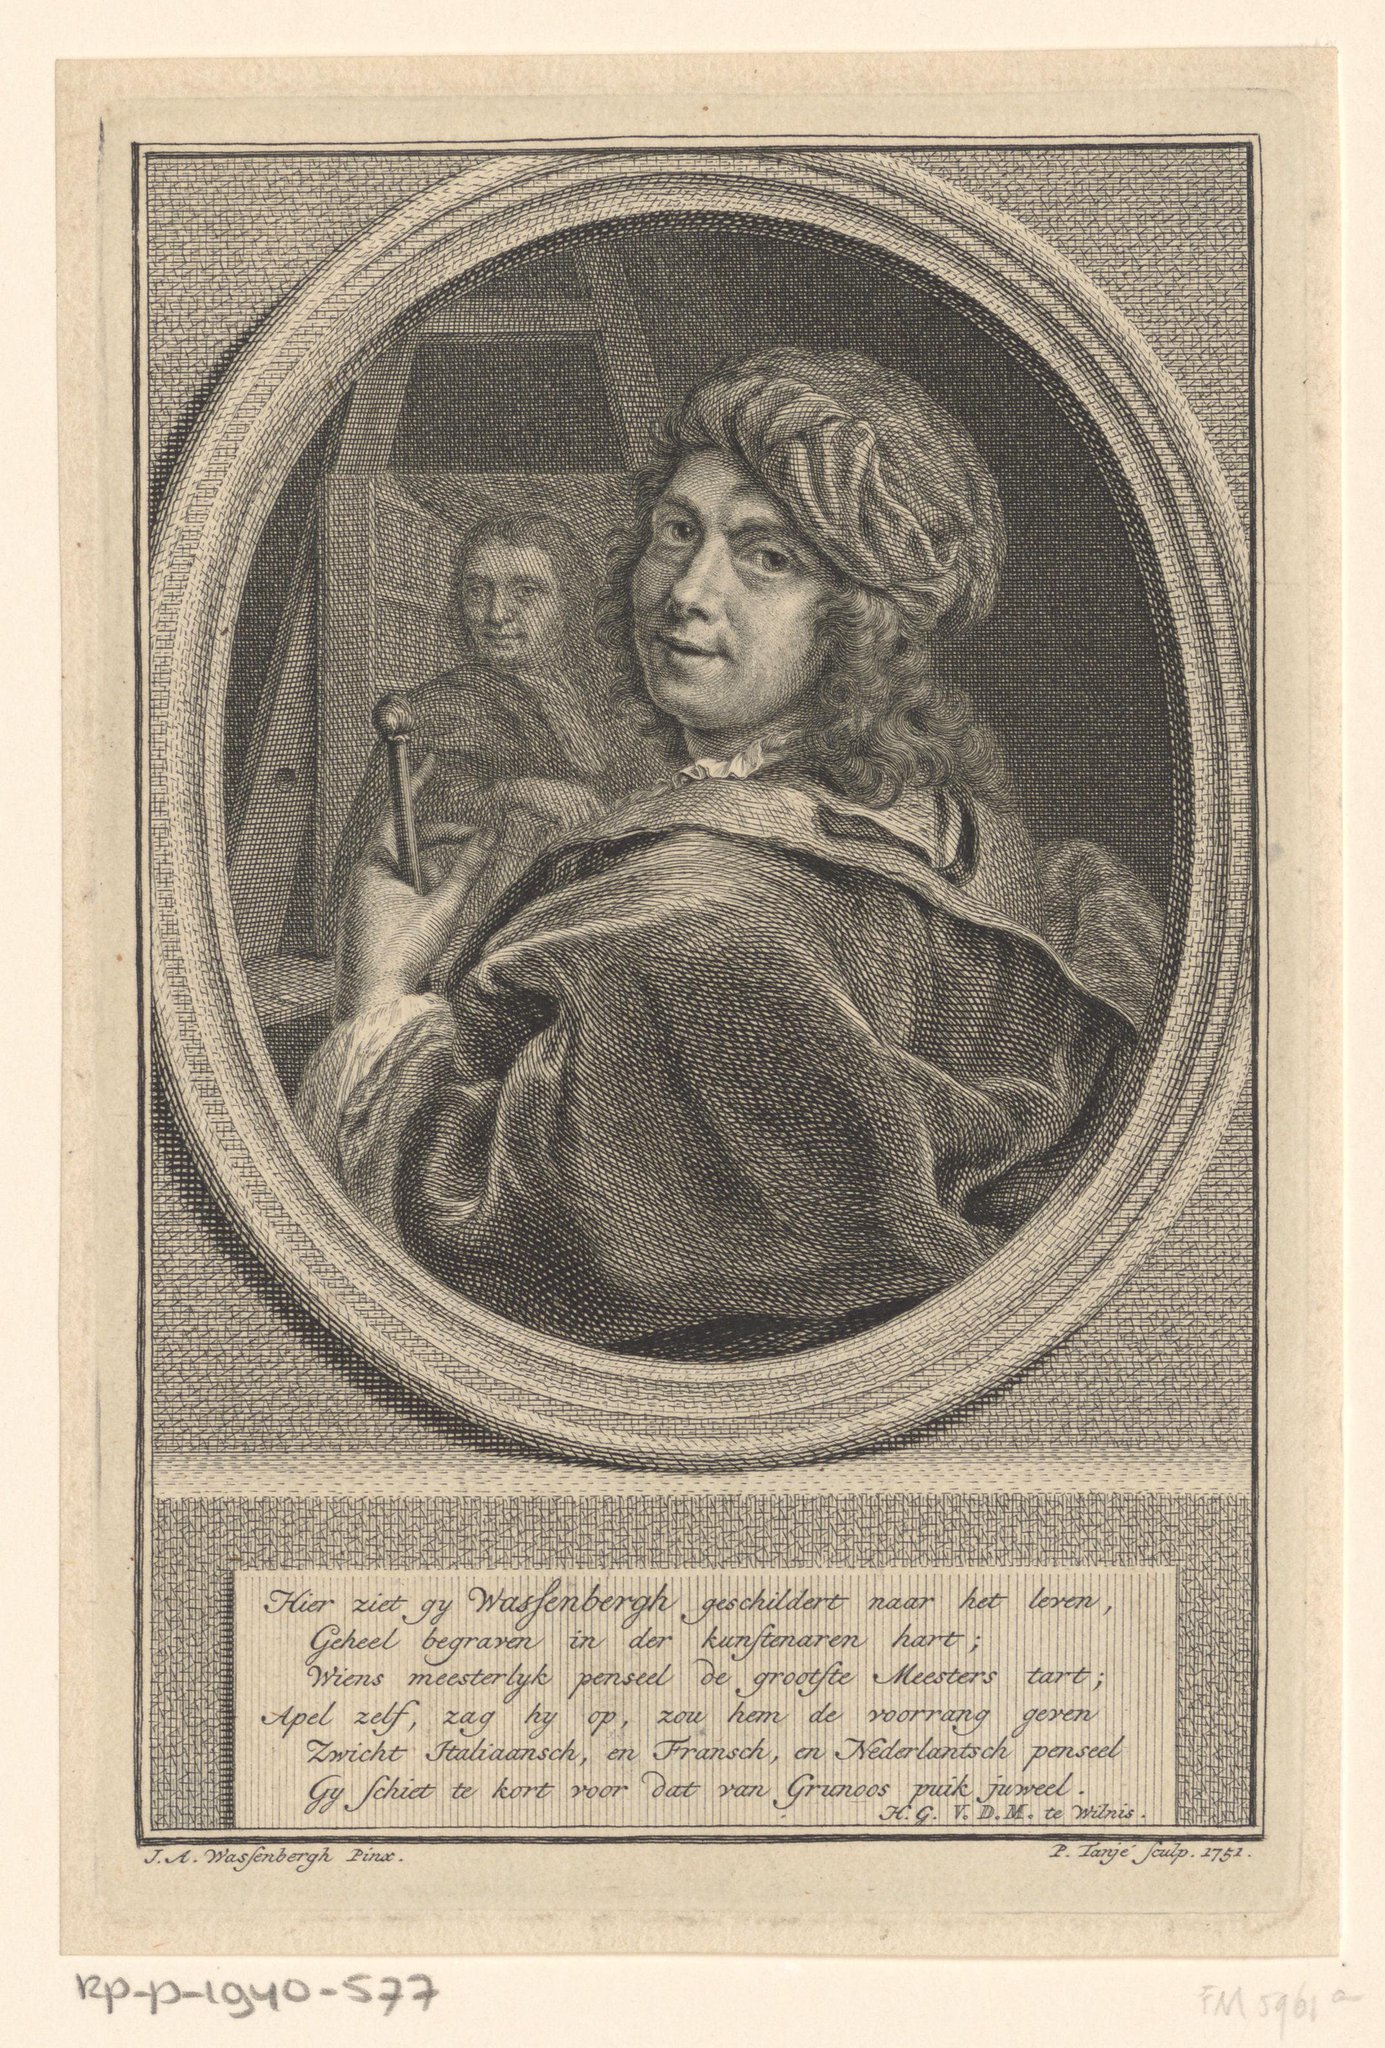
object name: print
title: Portret van Jan Abel Wassenbergh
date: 1751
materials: paper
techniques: engraving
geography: amsterdam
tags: painter, jan abel wassenbergh, historical persons, portrait, self-portrait of painter, brushes ~ implements of painter, working situations ~ painter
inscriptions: collector's mark: Lugt 2760, collector's mark: Lugt 2228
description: Onder het portret een zesregelig vers in het Nederlands.